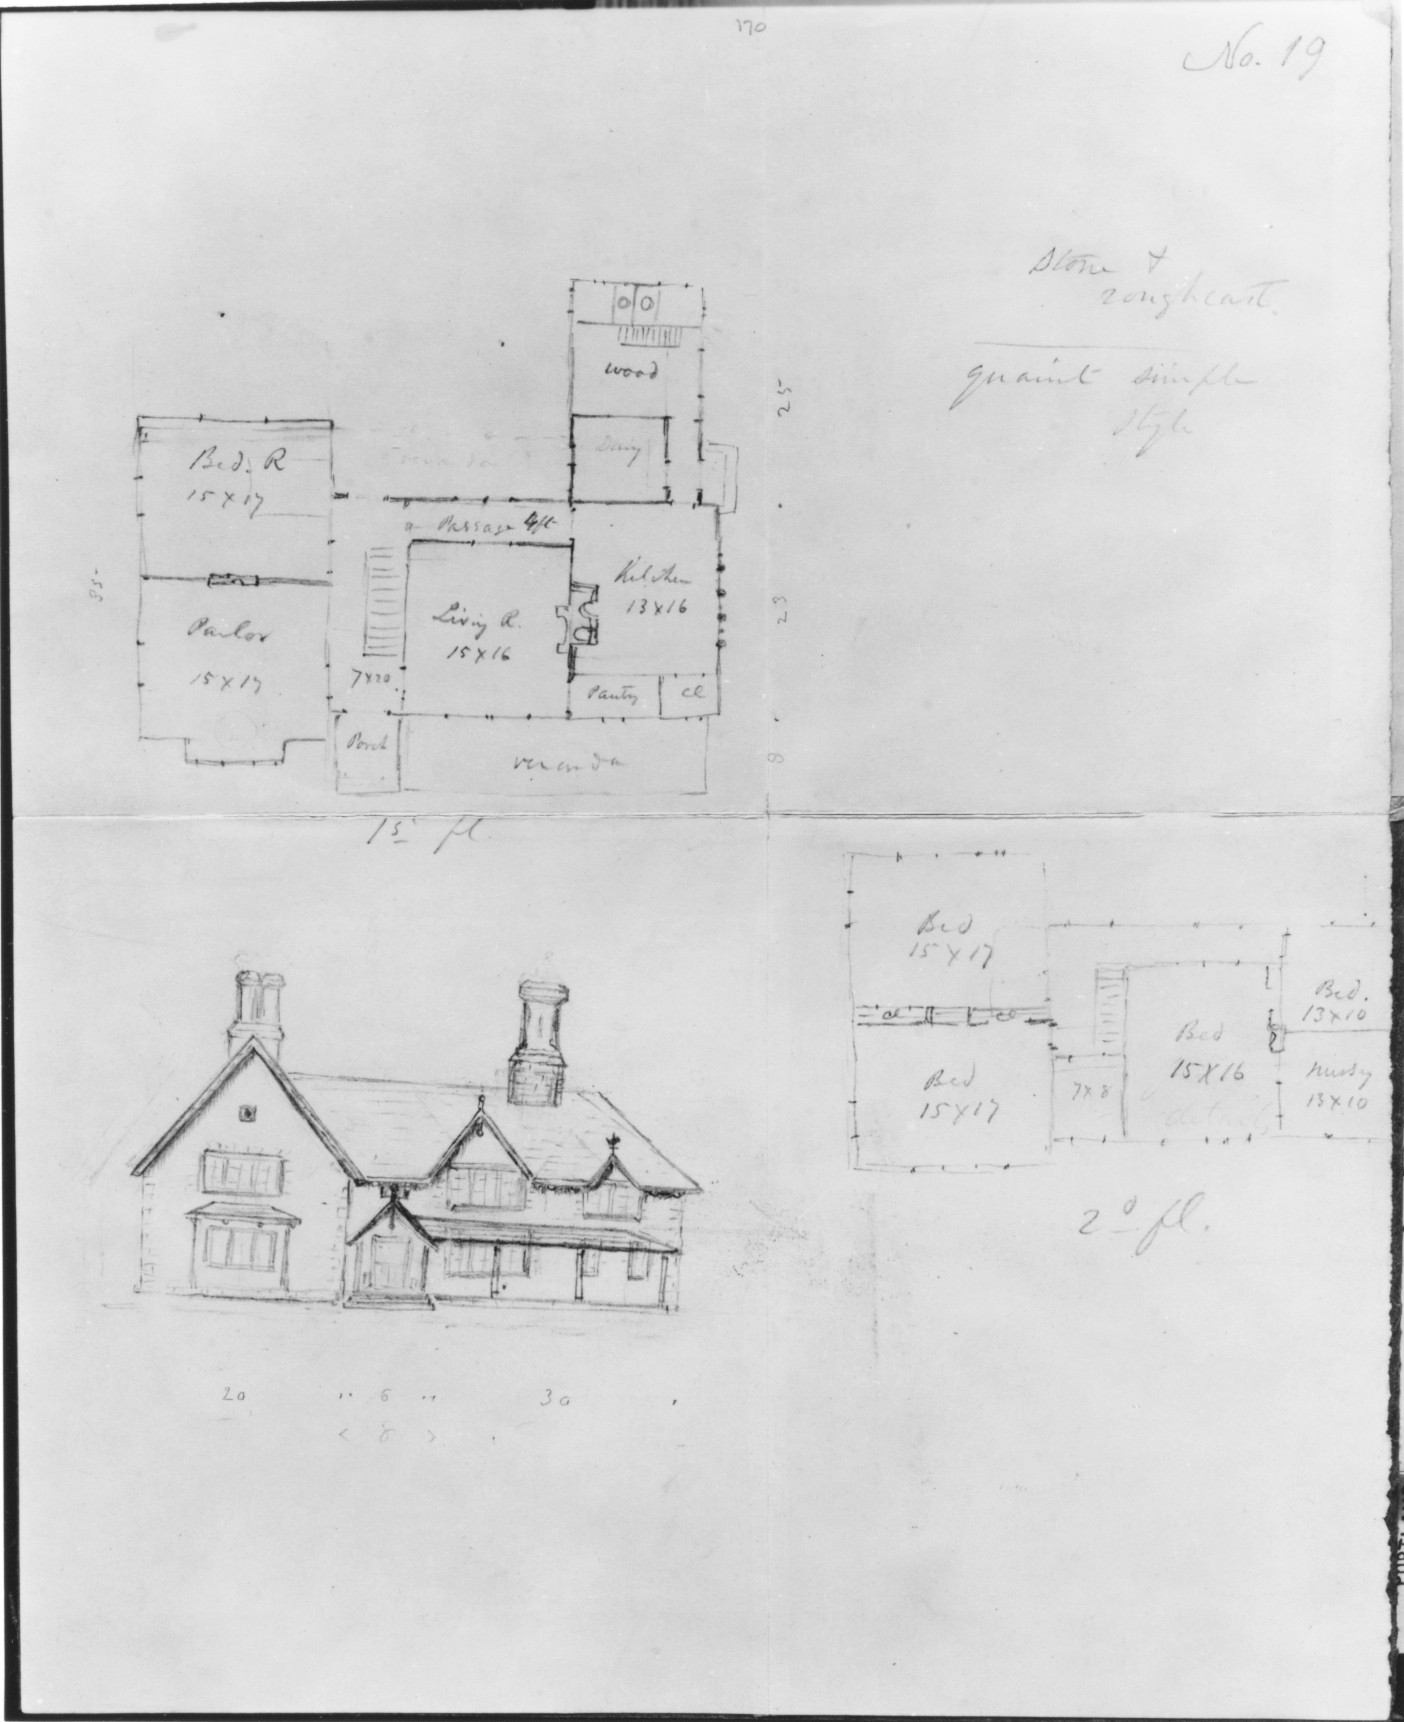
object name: book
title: The Architecture of Country Houses; including Designs for Cottages, Farm Houses, and Villas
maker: andrew jackson downing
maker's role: author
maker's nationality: american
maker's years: 1815-1852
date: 1850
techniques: drawing, lithograph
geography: philadelphia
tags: architecture,houses